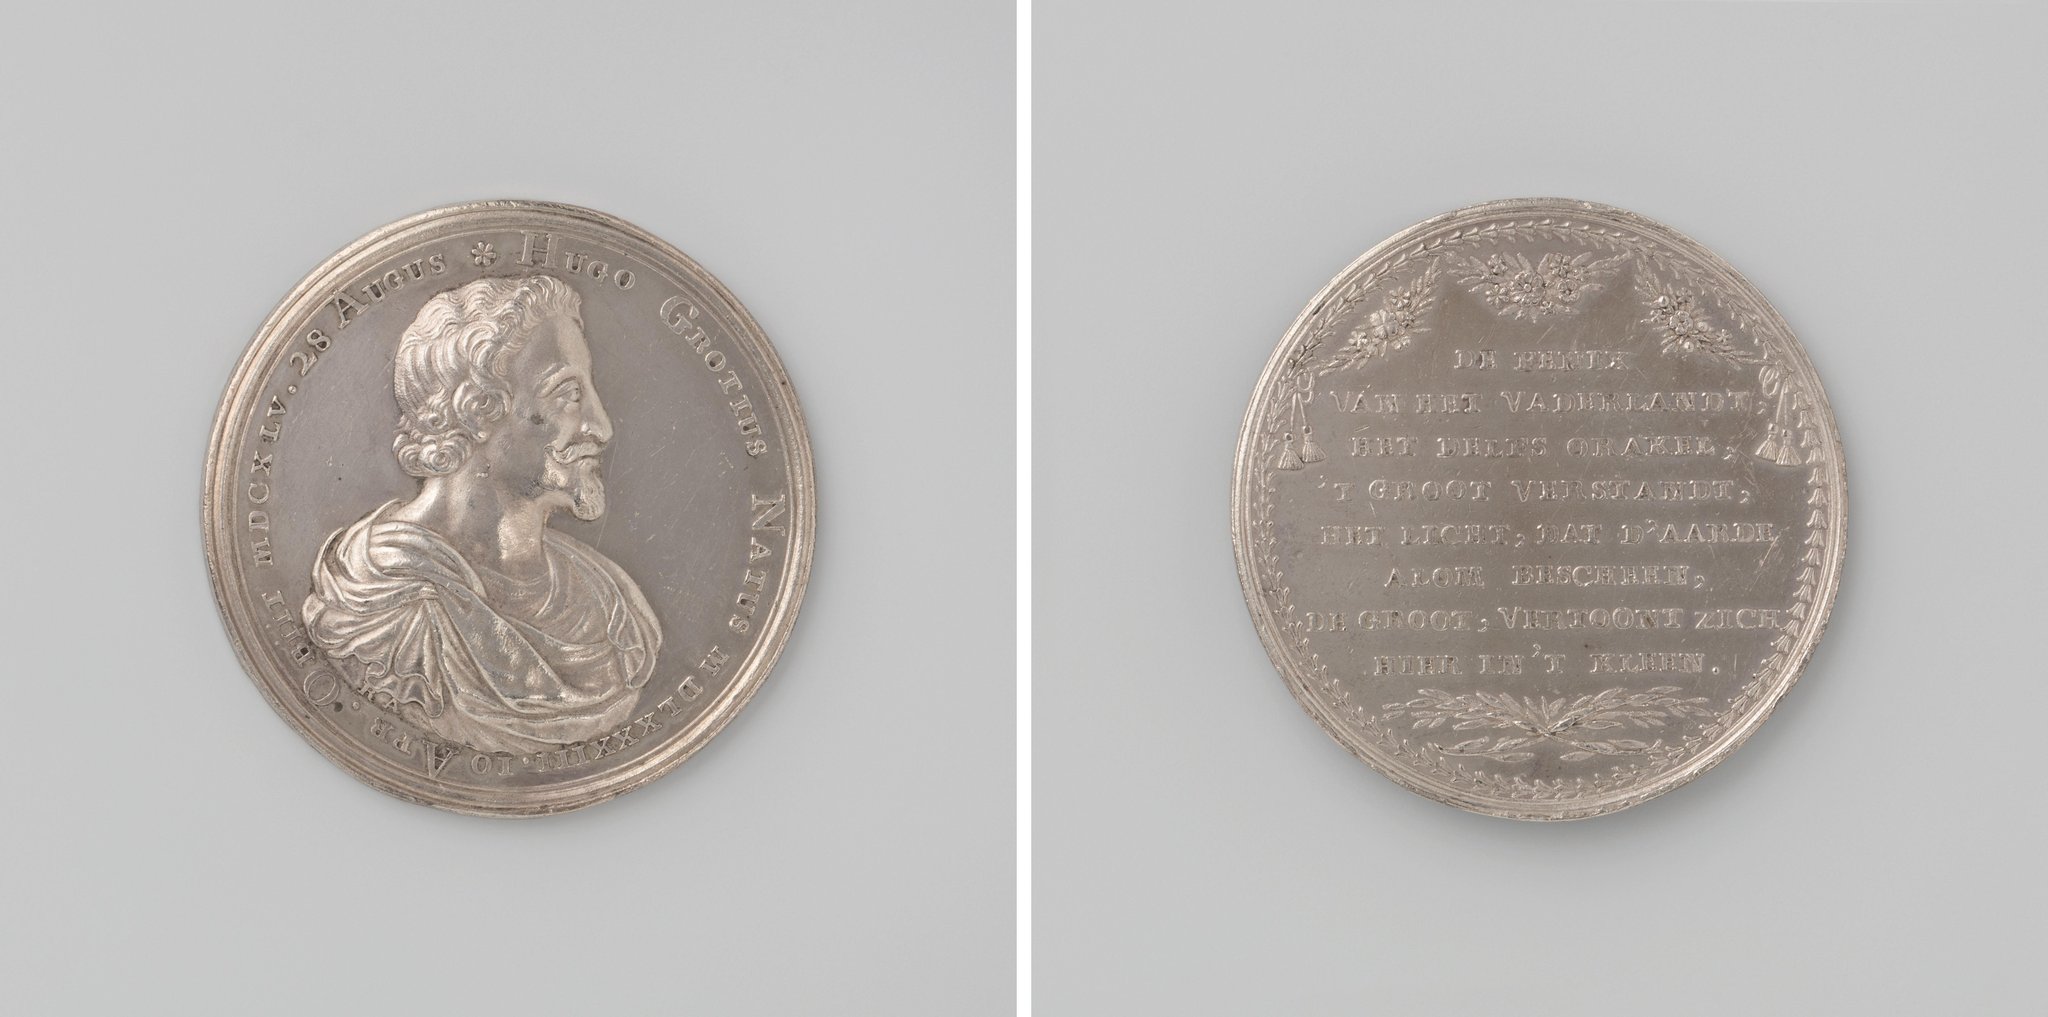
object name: history medal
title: Dood van Hugo de Groot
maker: reynier arondeaux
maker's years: 1678-1727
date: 1681-1682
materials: silver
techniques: striking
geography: amsterdam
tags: delft, hugo de groot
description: Zilveren penning. Voorzijde: borststuk man binnen omschrift. Keerzijde: opschrift onder bloemtakken, boven twee gekruiste lauwerkrans, binnen krans